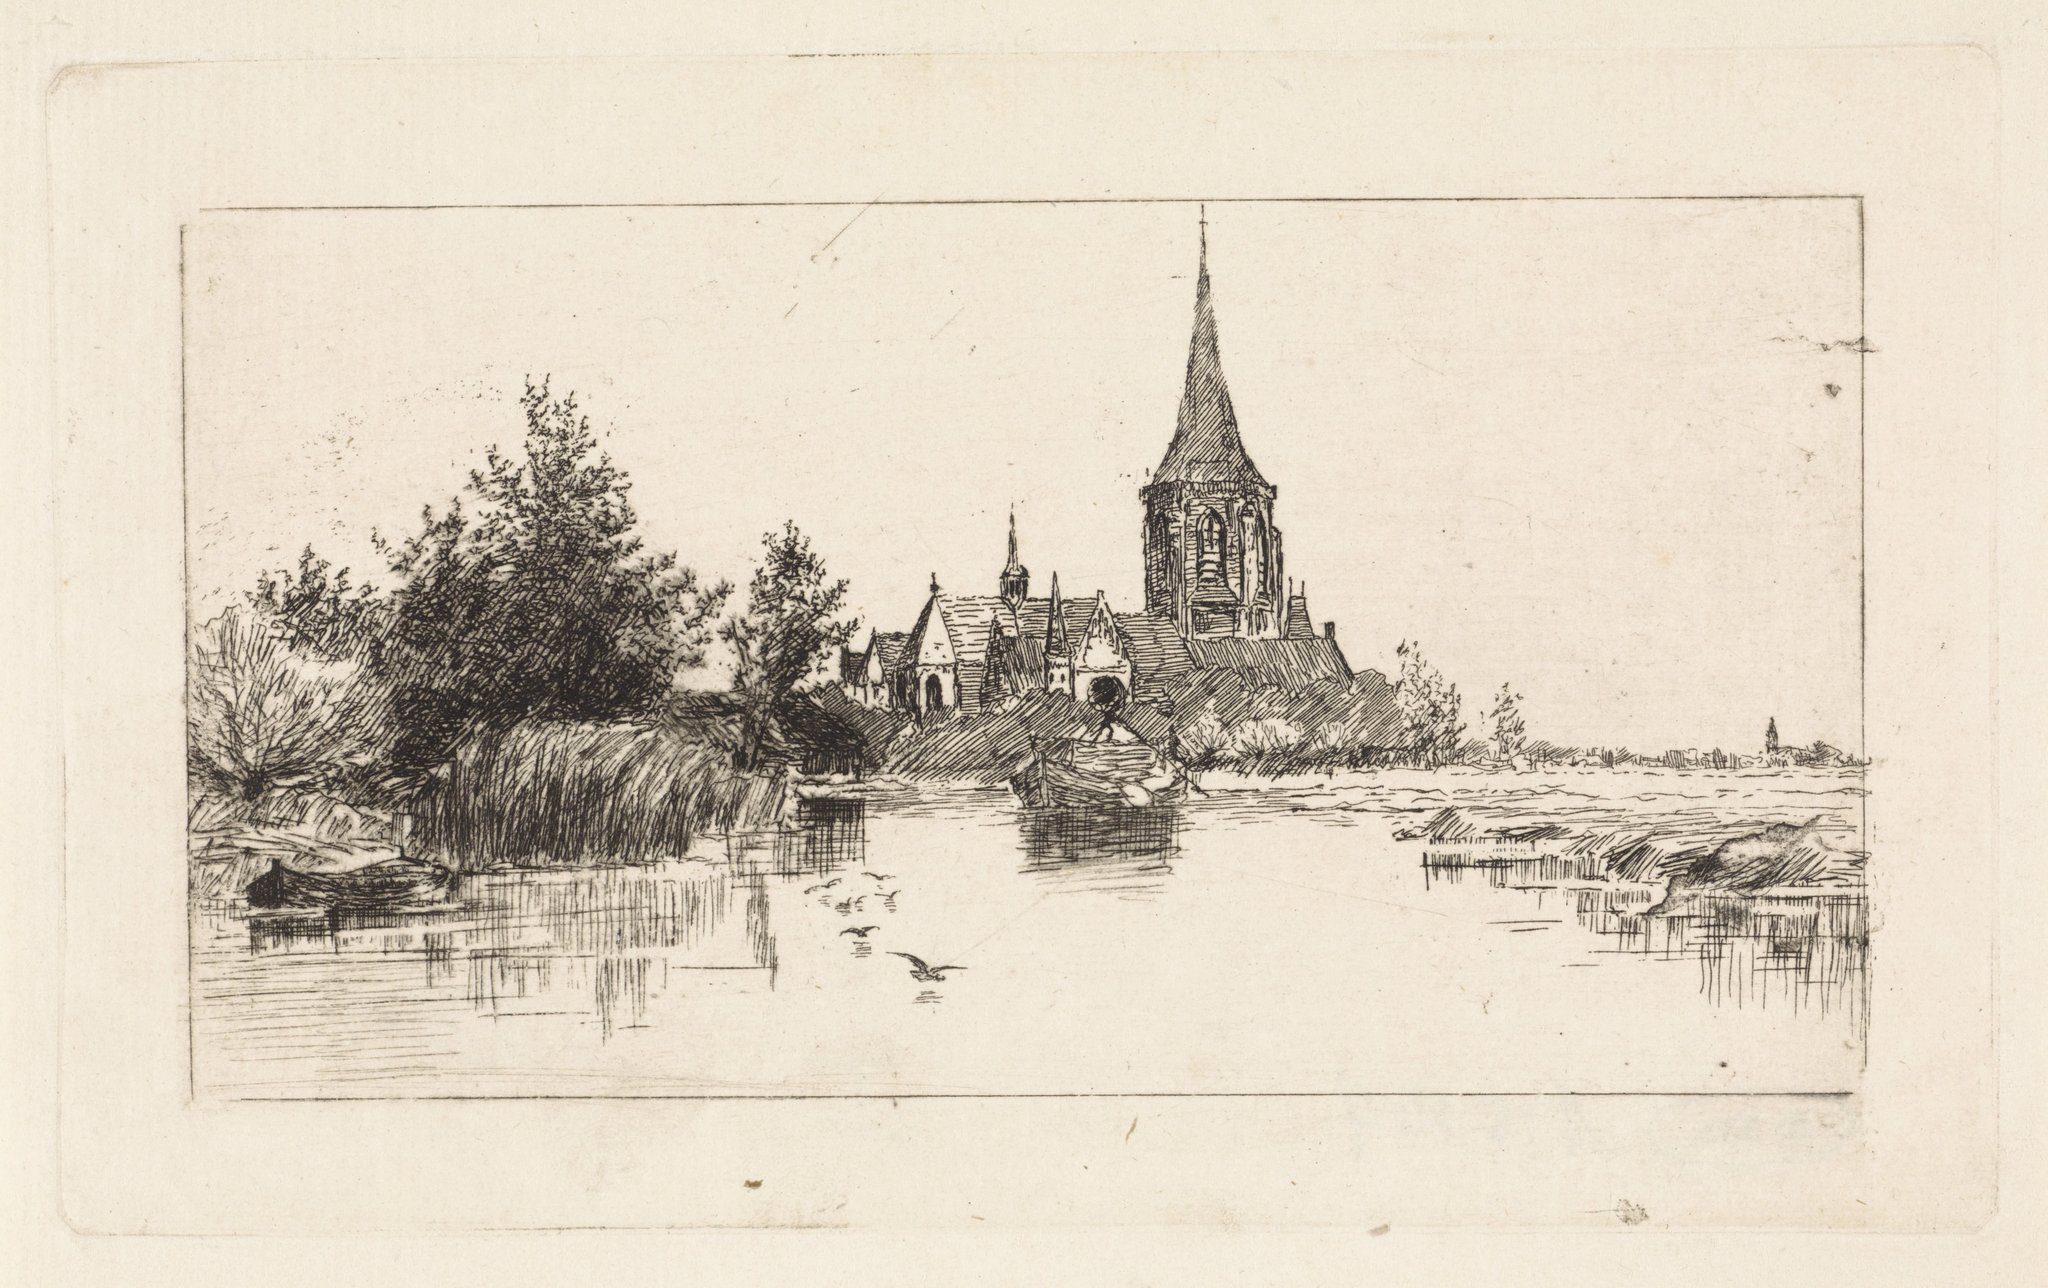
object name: print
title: Sint Urbanuskerk te Bovenkerk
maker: elias stark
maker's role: draughtsman, print maker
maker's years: 1849-1933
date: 1887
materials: paper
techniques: aquatint, etching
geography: nieuwer-amstel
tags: church (exterior)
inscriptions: collector's mark: Lugt 2228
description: De St. Urbanuskerk te Bovenkerk gezien vanaf het water.